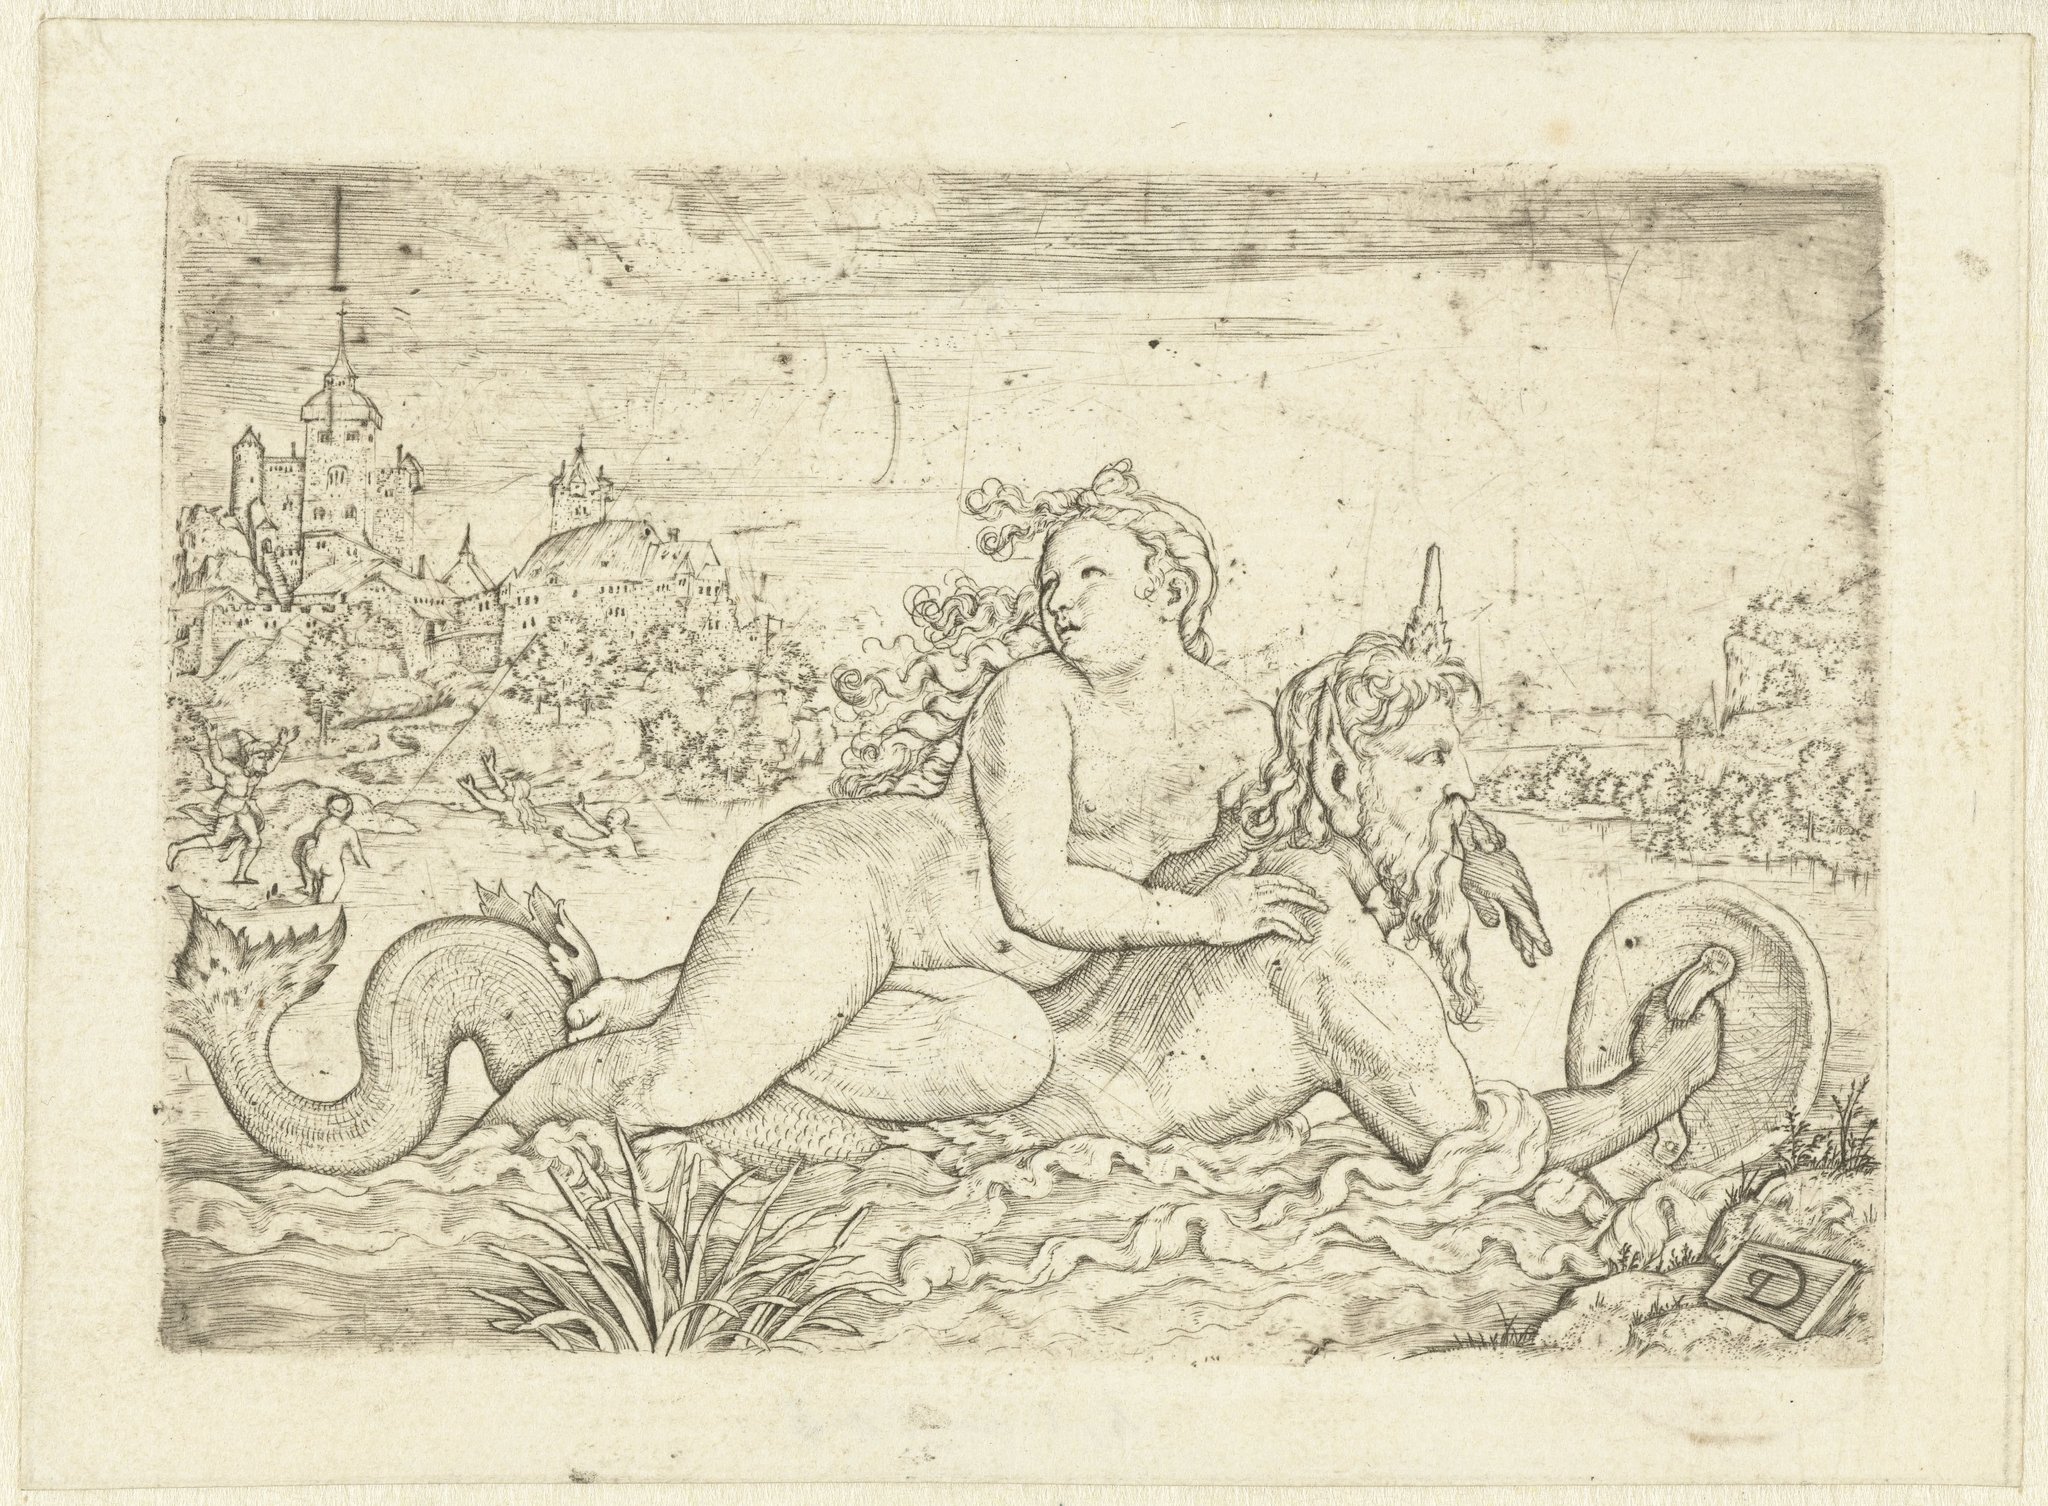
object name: print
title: Neptunus redt Amymone van de satyr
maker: Anonymous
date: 1500-1578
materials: paper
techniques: engraving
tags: neptune rescues amymone from the satyr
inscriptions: collector's mark: Lugt 240